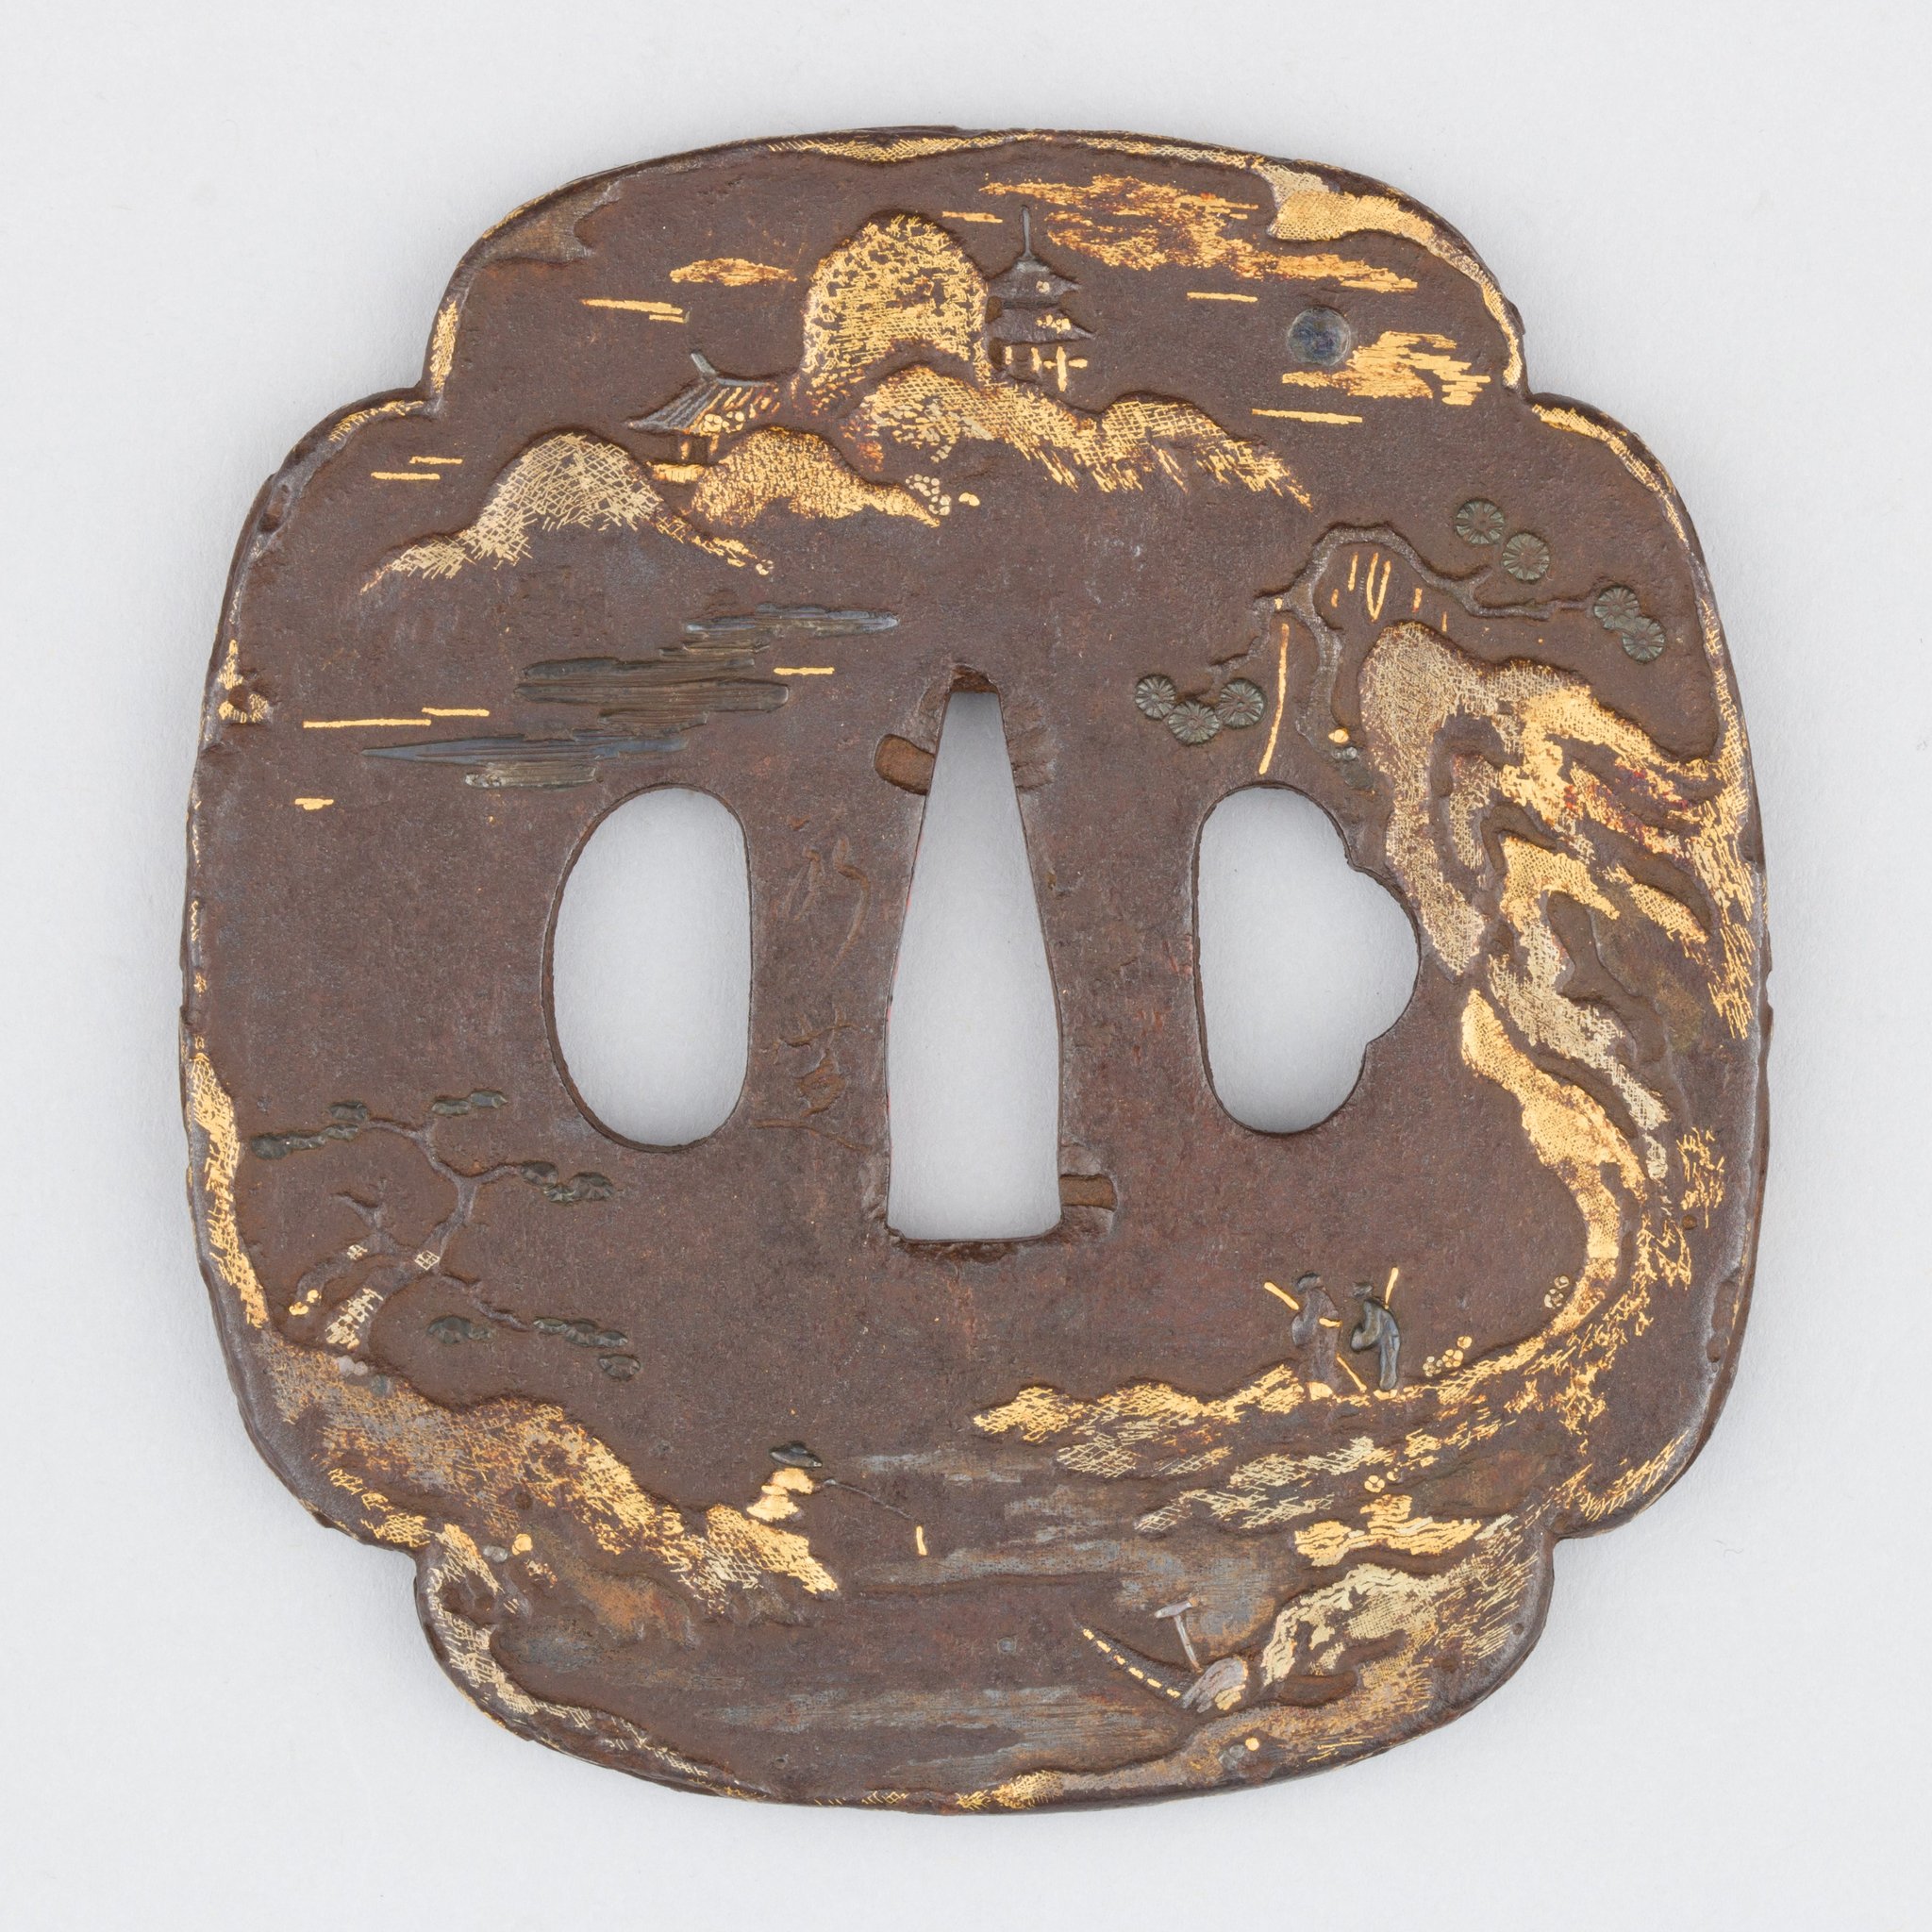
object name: sword guard tsuba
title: Sword Guard (Tsuba)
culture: japanese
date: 1601-1800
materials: copper, gold, iron, silver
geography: japan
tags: landscapes